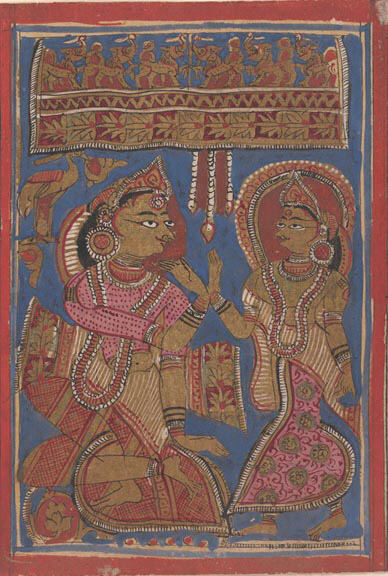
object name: folio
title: Queen Trisala's Grief (at the Stillness of the Unborn): Folio from a Kalpasutra Manuscript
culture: indian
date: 1401-1500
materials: gold, ink, paper, watercolor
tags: queens